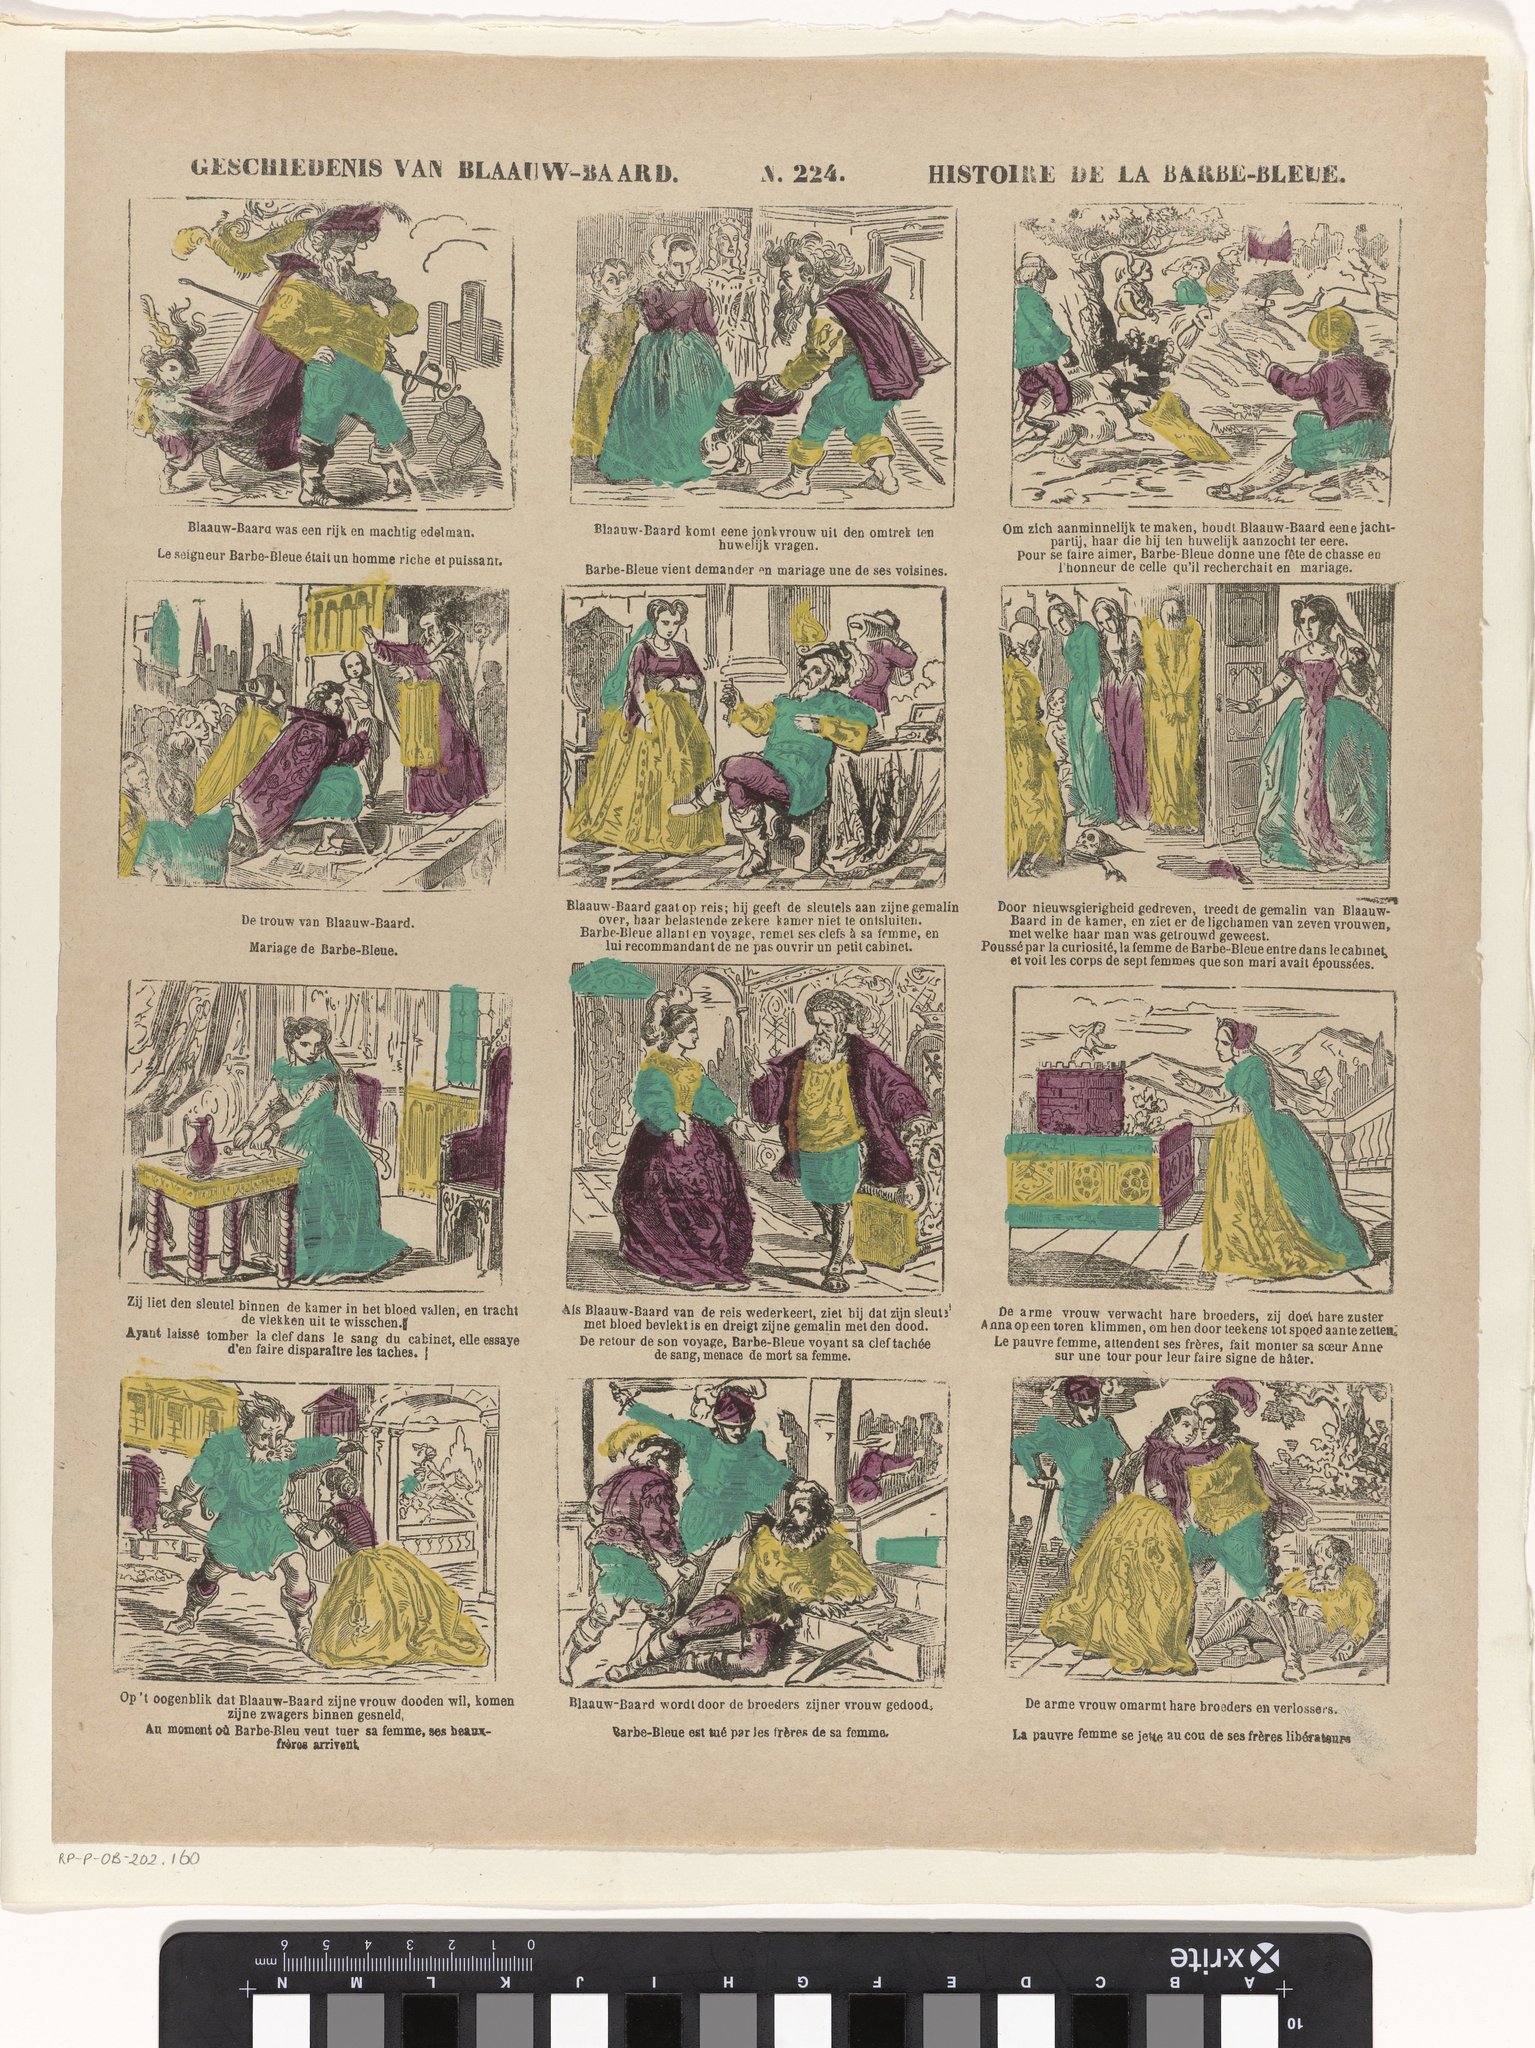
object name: popular print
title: Geschiedenis van Blaauw-baard / Histoire de la Barbe-bleue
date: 1800-1833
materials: paper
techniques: colour, letterpress printing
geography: turnhout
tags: tales and fairy tales (with title)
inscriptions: collector's mark: Lugt 2760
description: Blad met 12 voorstellingen uit het sprookje van Blauwbaard. Onder elke voorstelling een onderschrift in het Nederlands en in het Frans. Genummerd midden boven: N. 224.